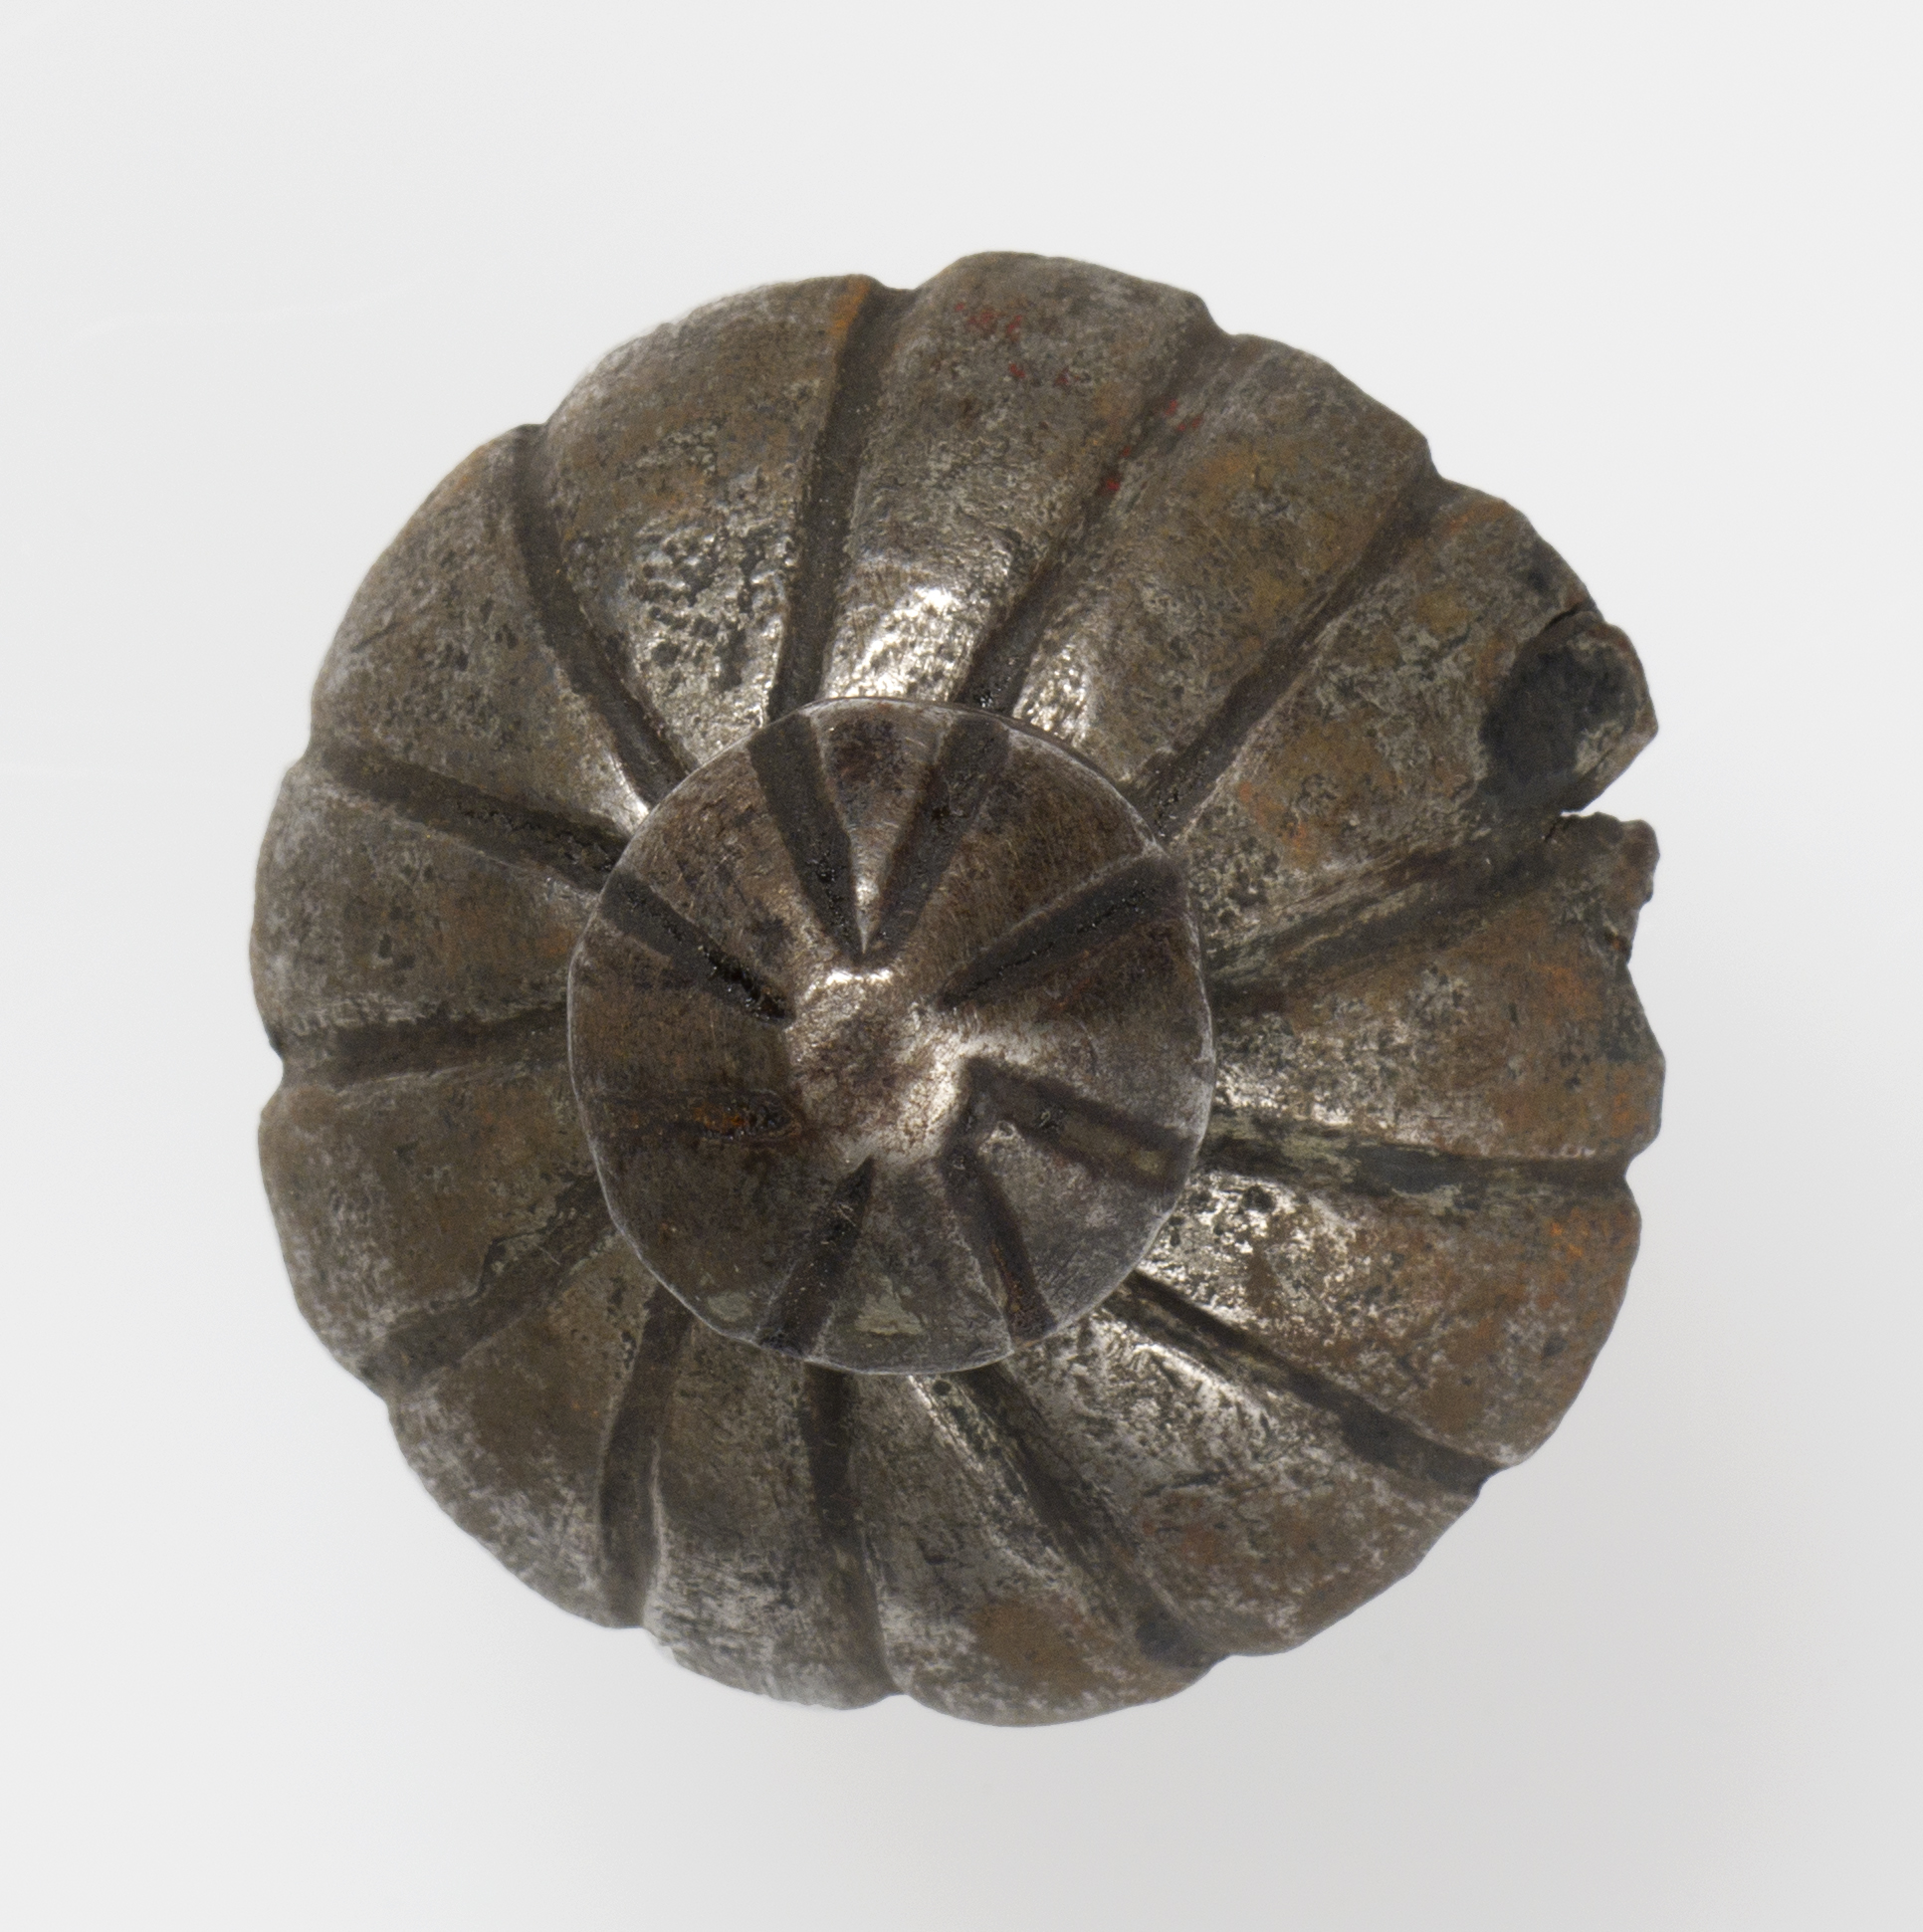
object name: bos and nail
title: Boss and Nail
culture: european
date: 1401-1600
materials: iron